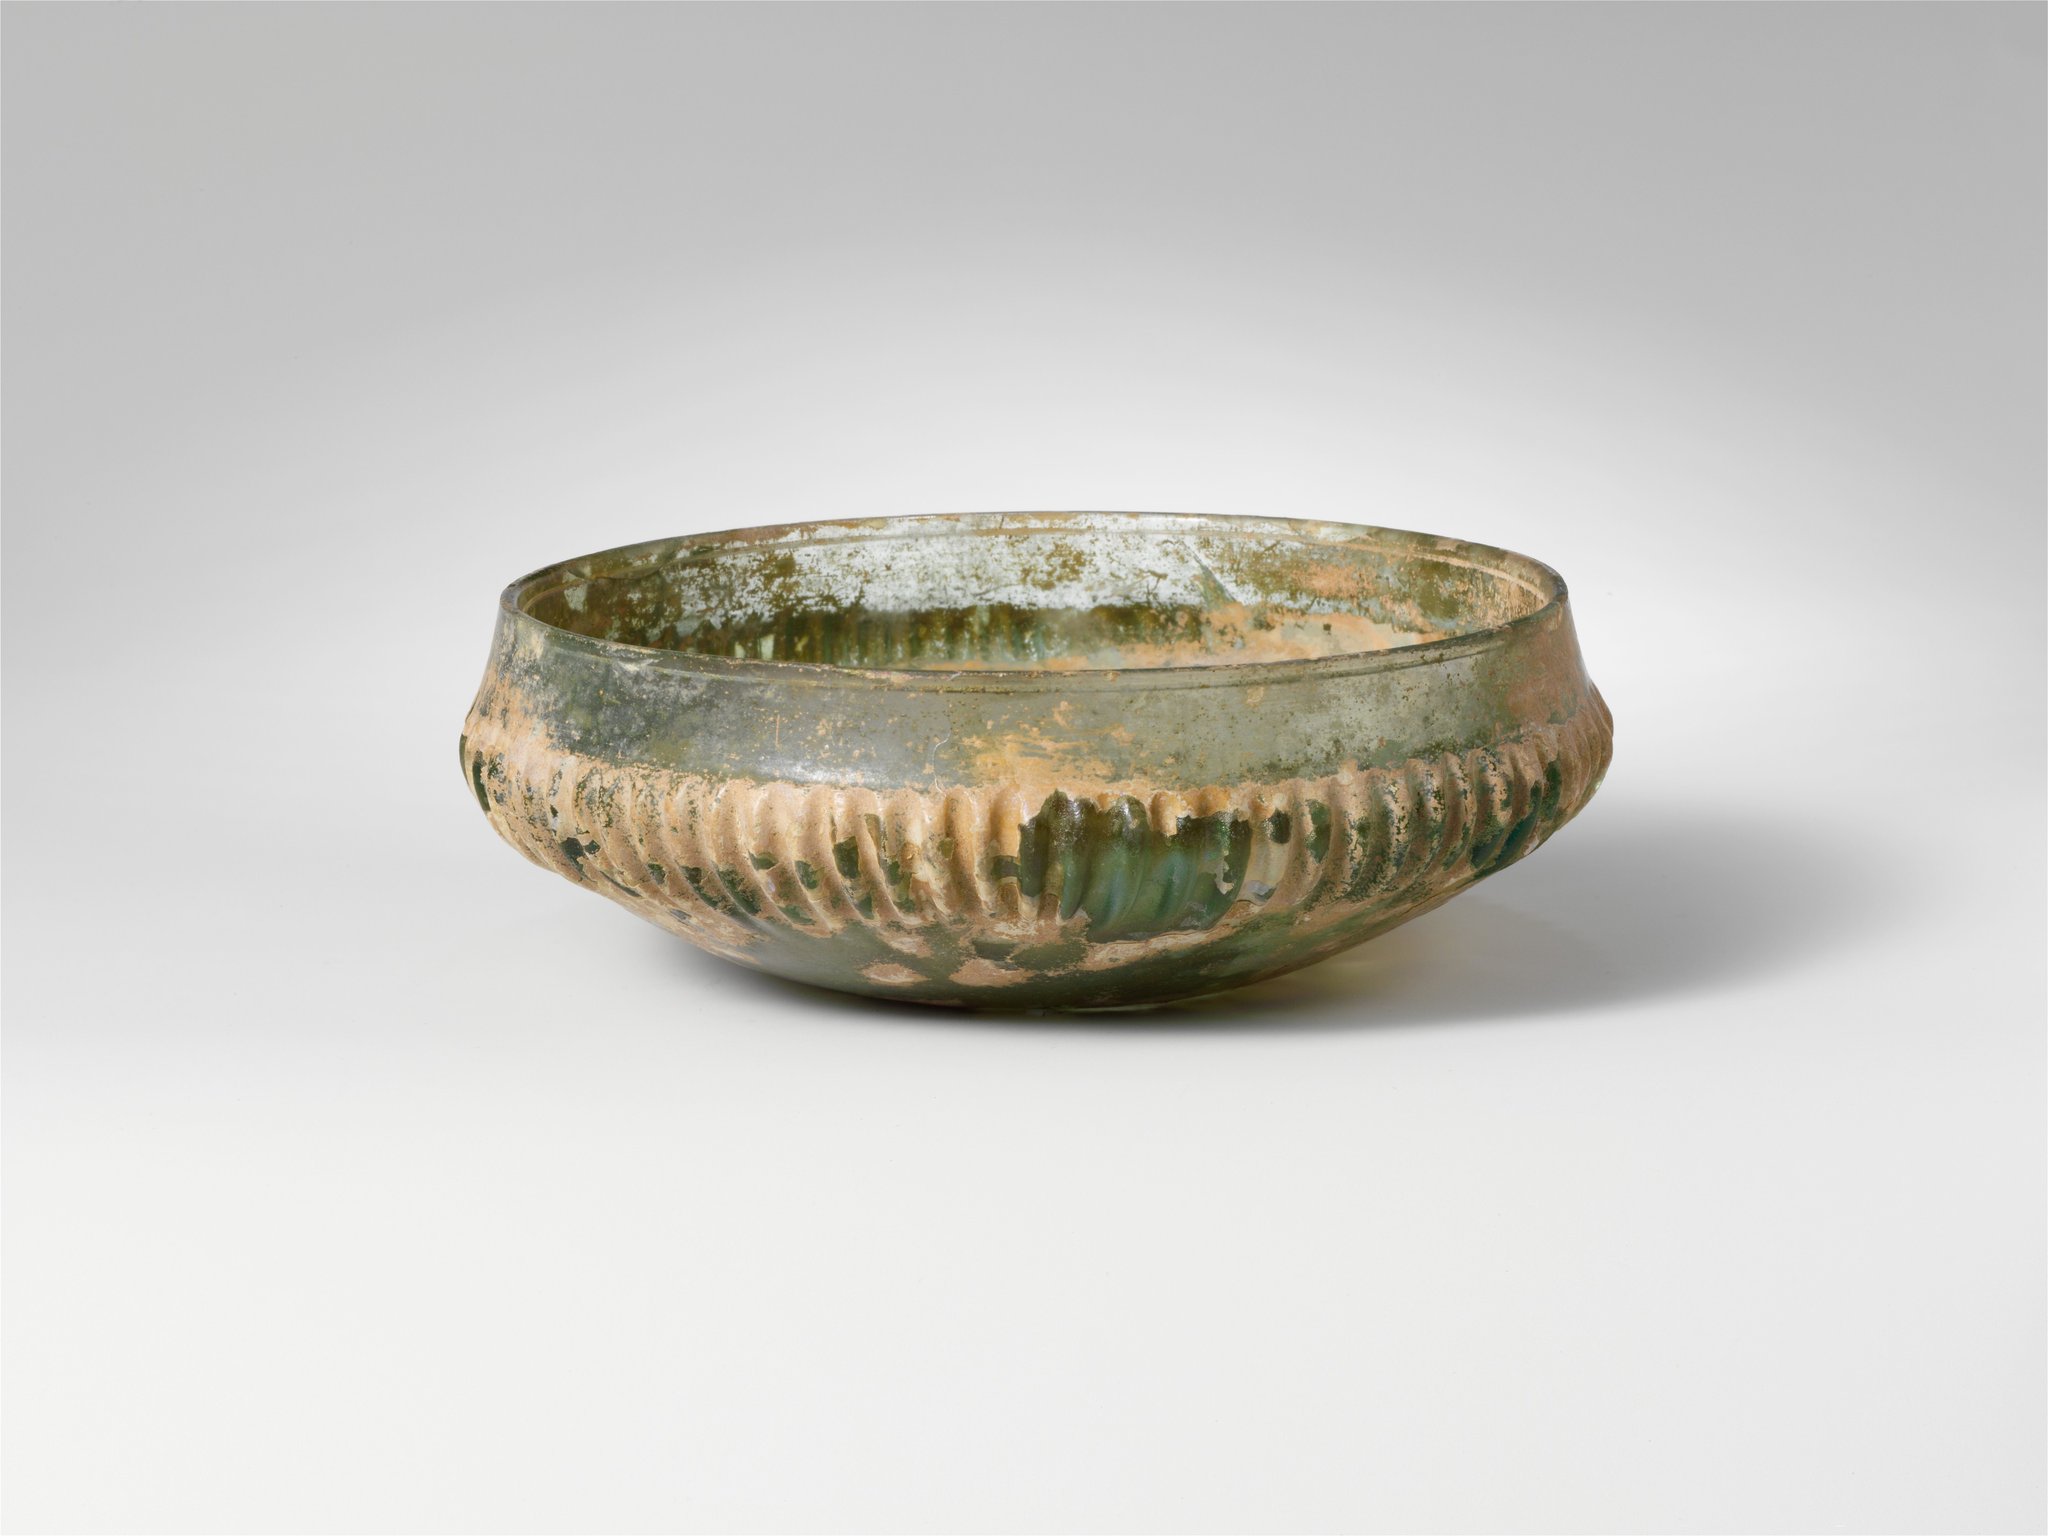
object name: bowl, ribbed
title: Glass ribbed bowl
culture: roman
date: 34 BCE-66 CE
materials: glass